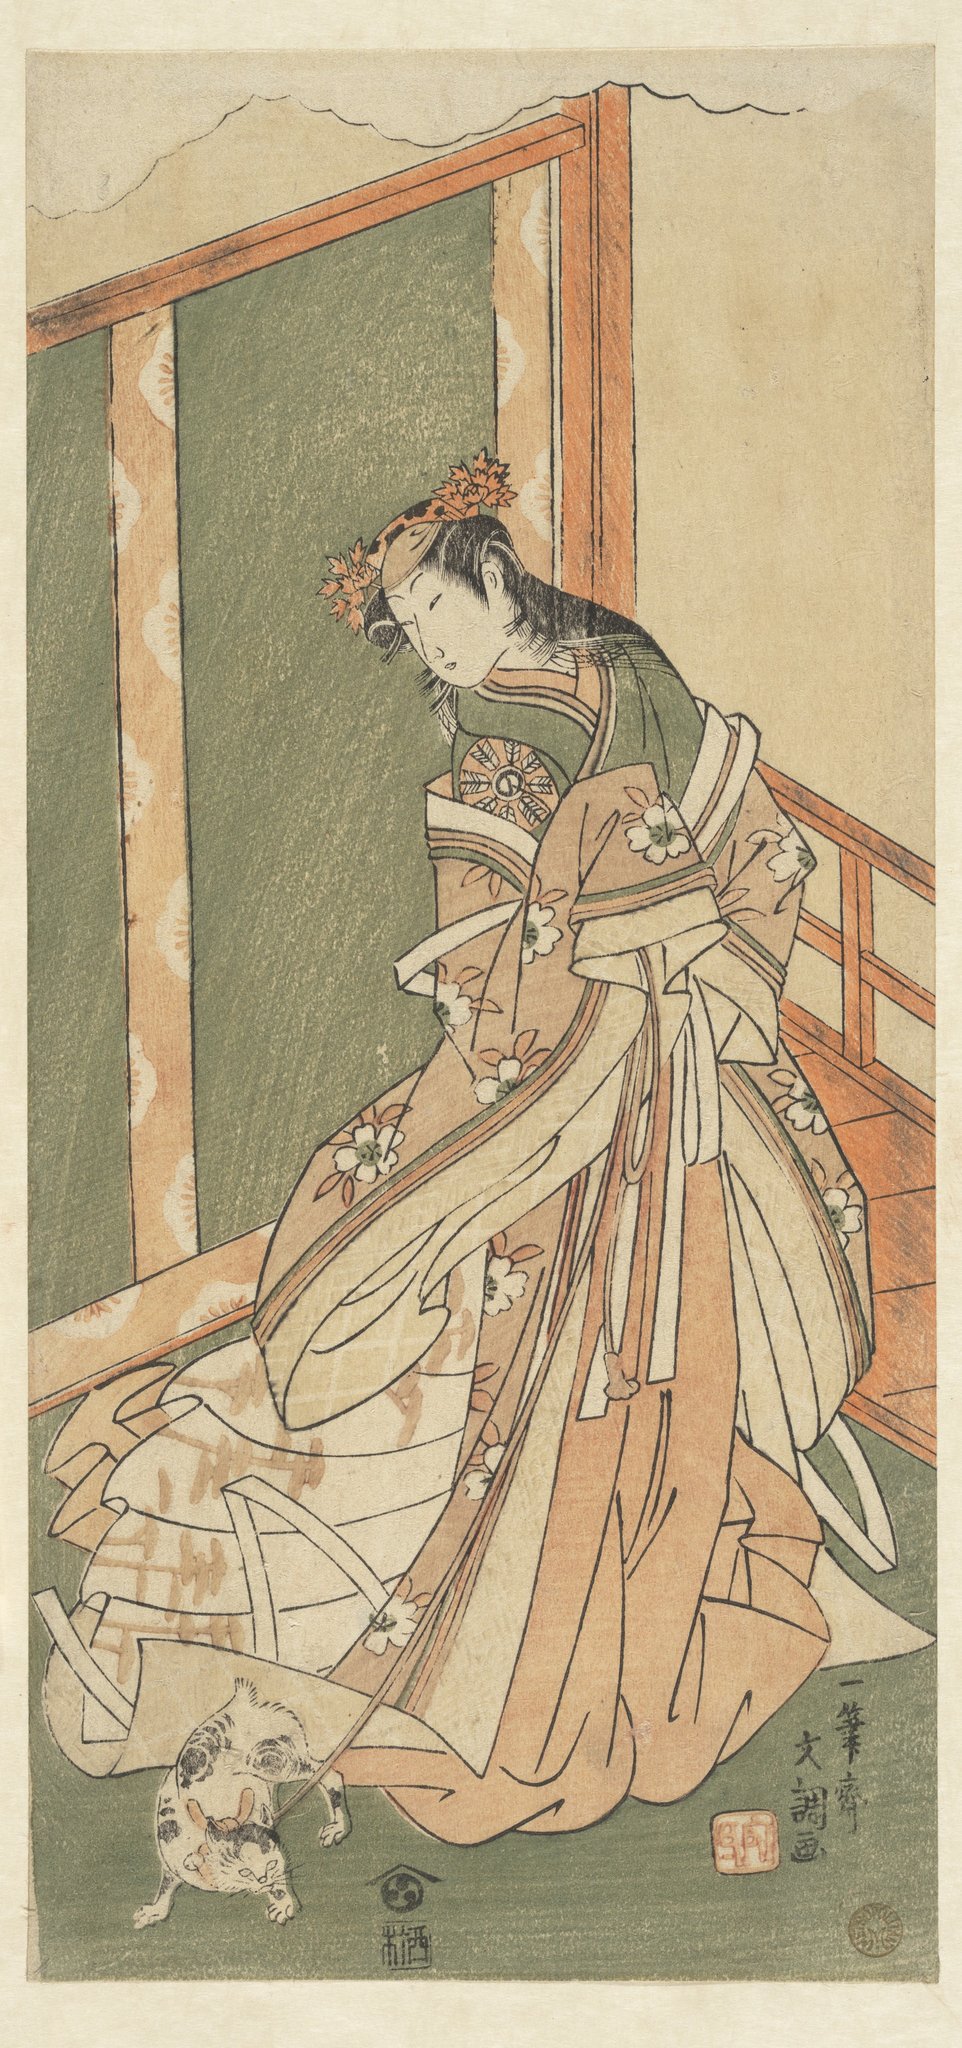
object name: print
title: The Third Princess (Onna San no Miya)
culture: japanese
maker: ippitsusai bunchō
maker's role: artist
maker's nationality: japanese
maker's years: 1765-1792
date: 1771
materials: ink, paper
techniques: woodblock print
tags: animals,princesses